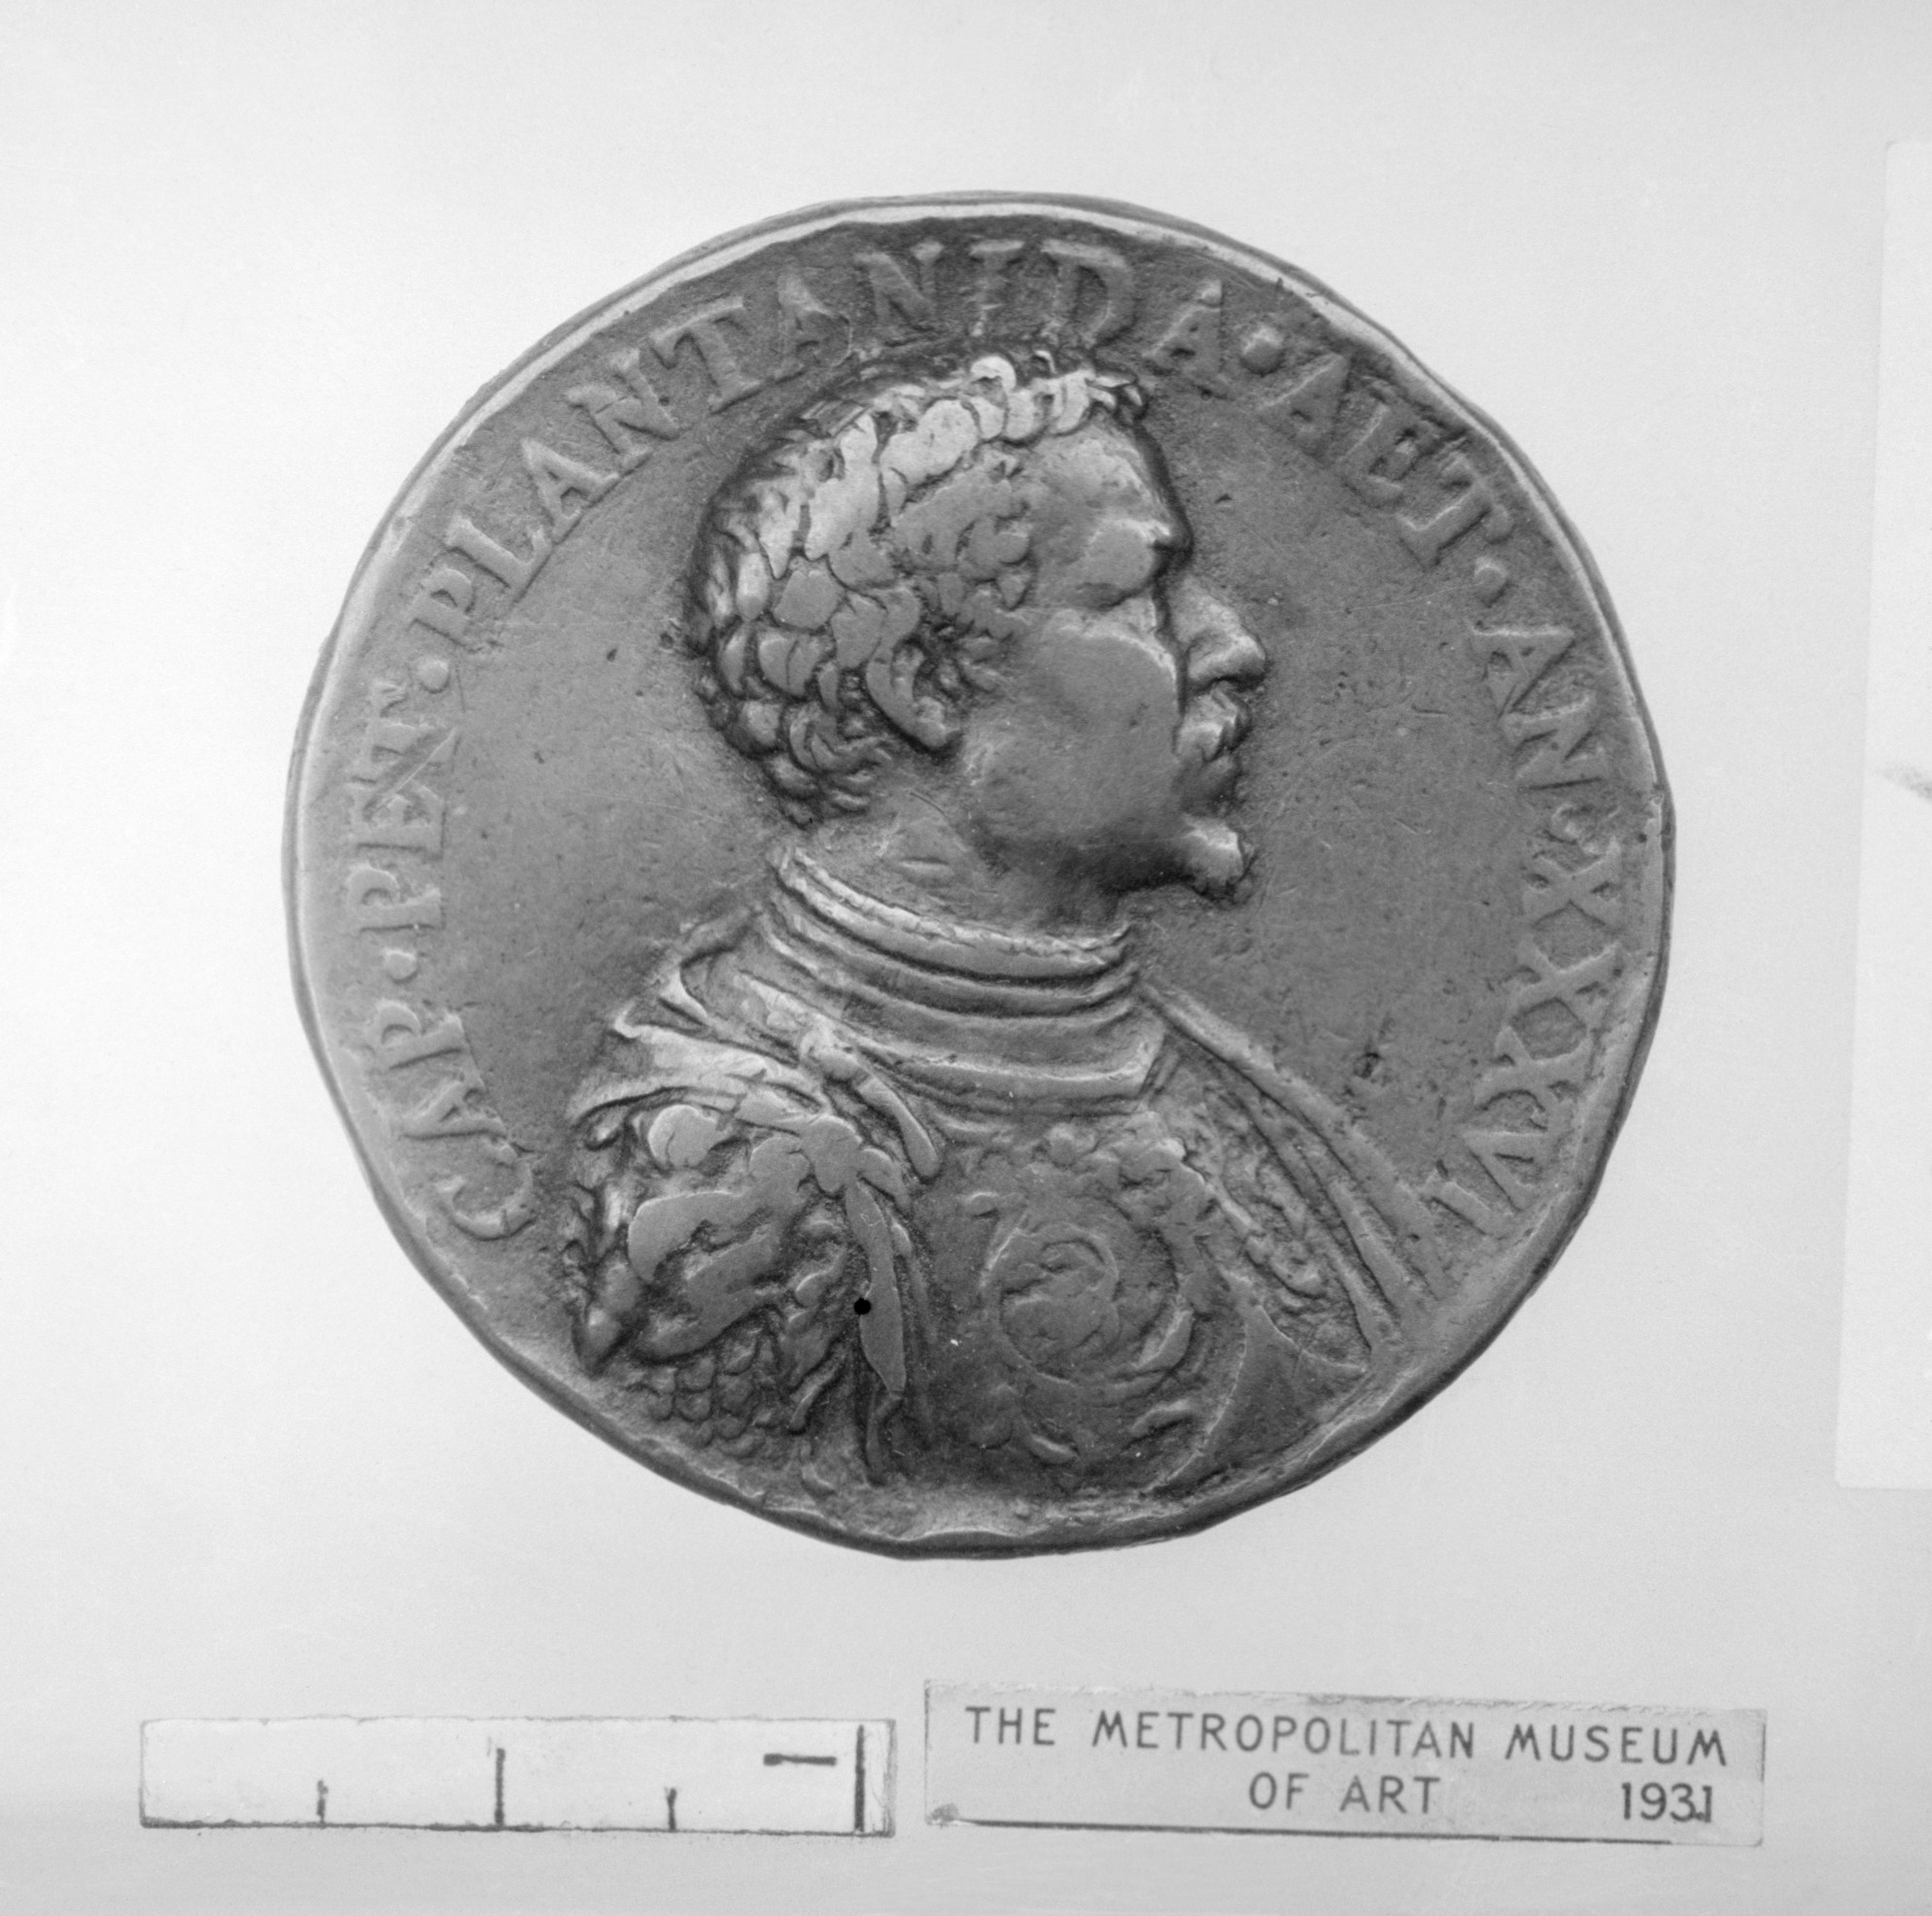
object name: medal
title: Pietro Piantanida of Milan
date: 1501-1600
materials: bronze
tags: men,profiles